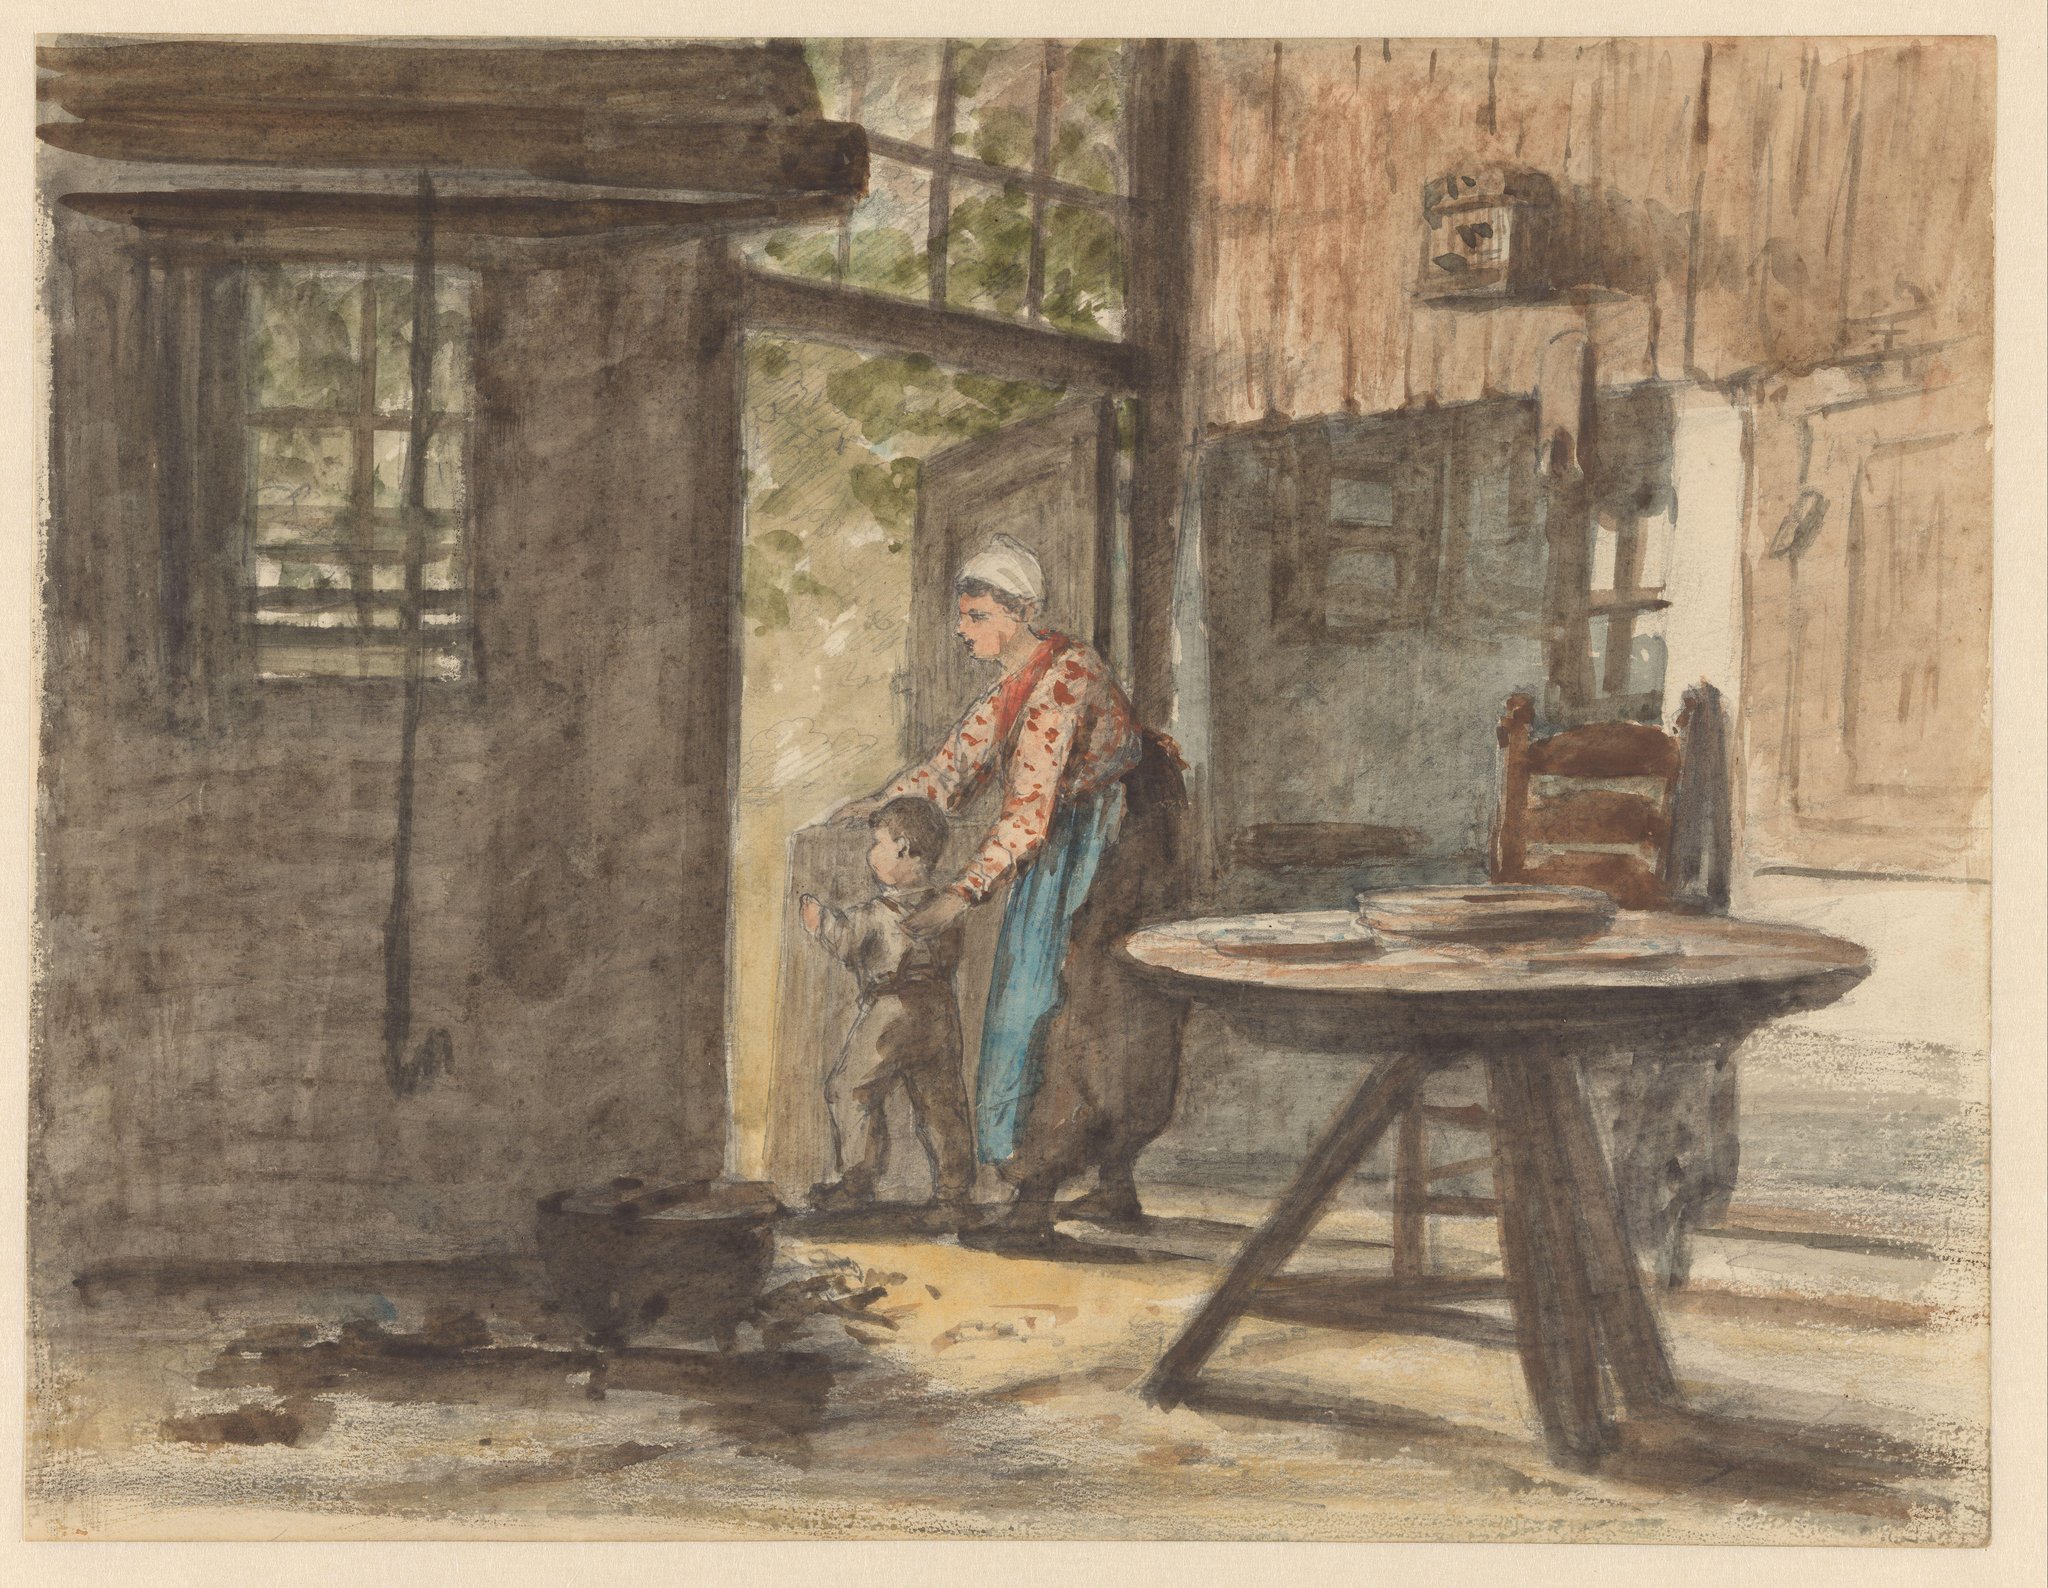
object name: drawing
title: Vrouw laat jongetje naar buiten gaan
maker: hendrik valkenburg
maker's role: draughtsman, painter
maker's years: 1826-1896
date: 1836-1896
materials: paper, watercolor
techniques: brush